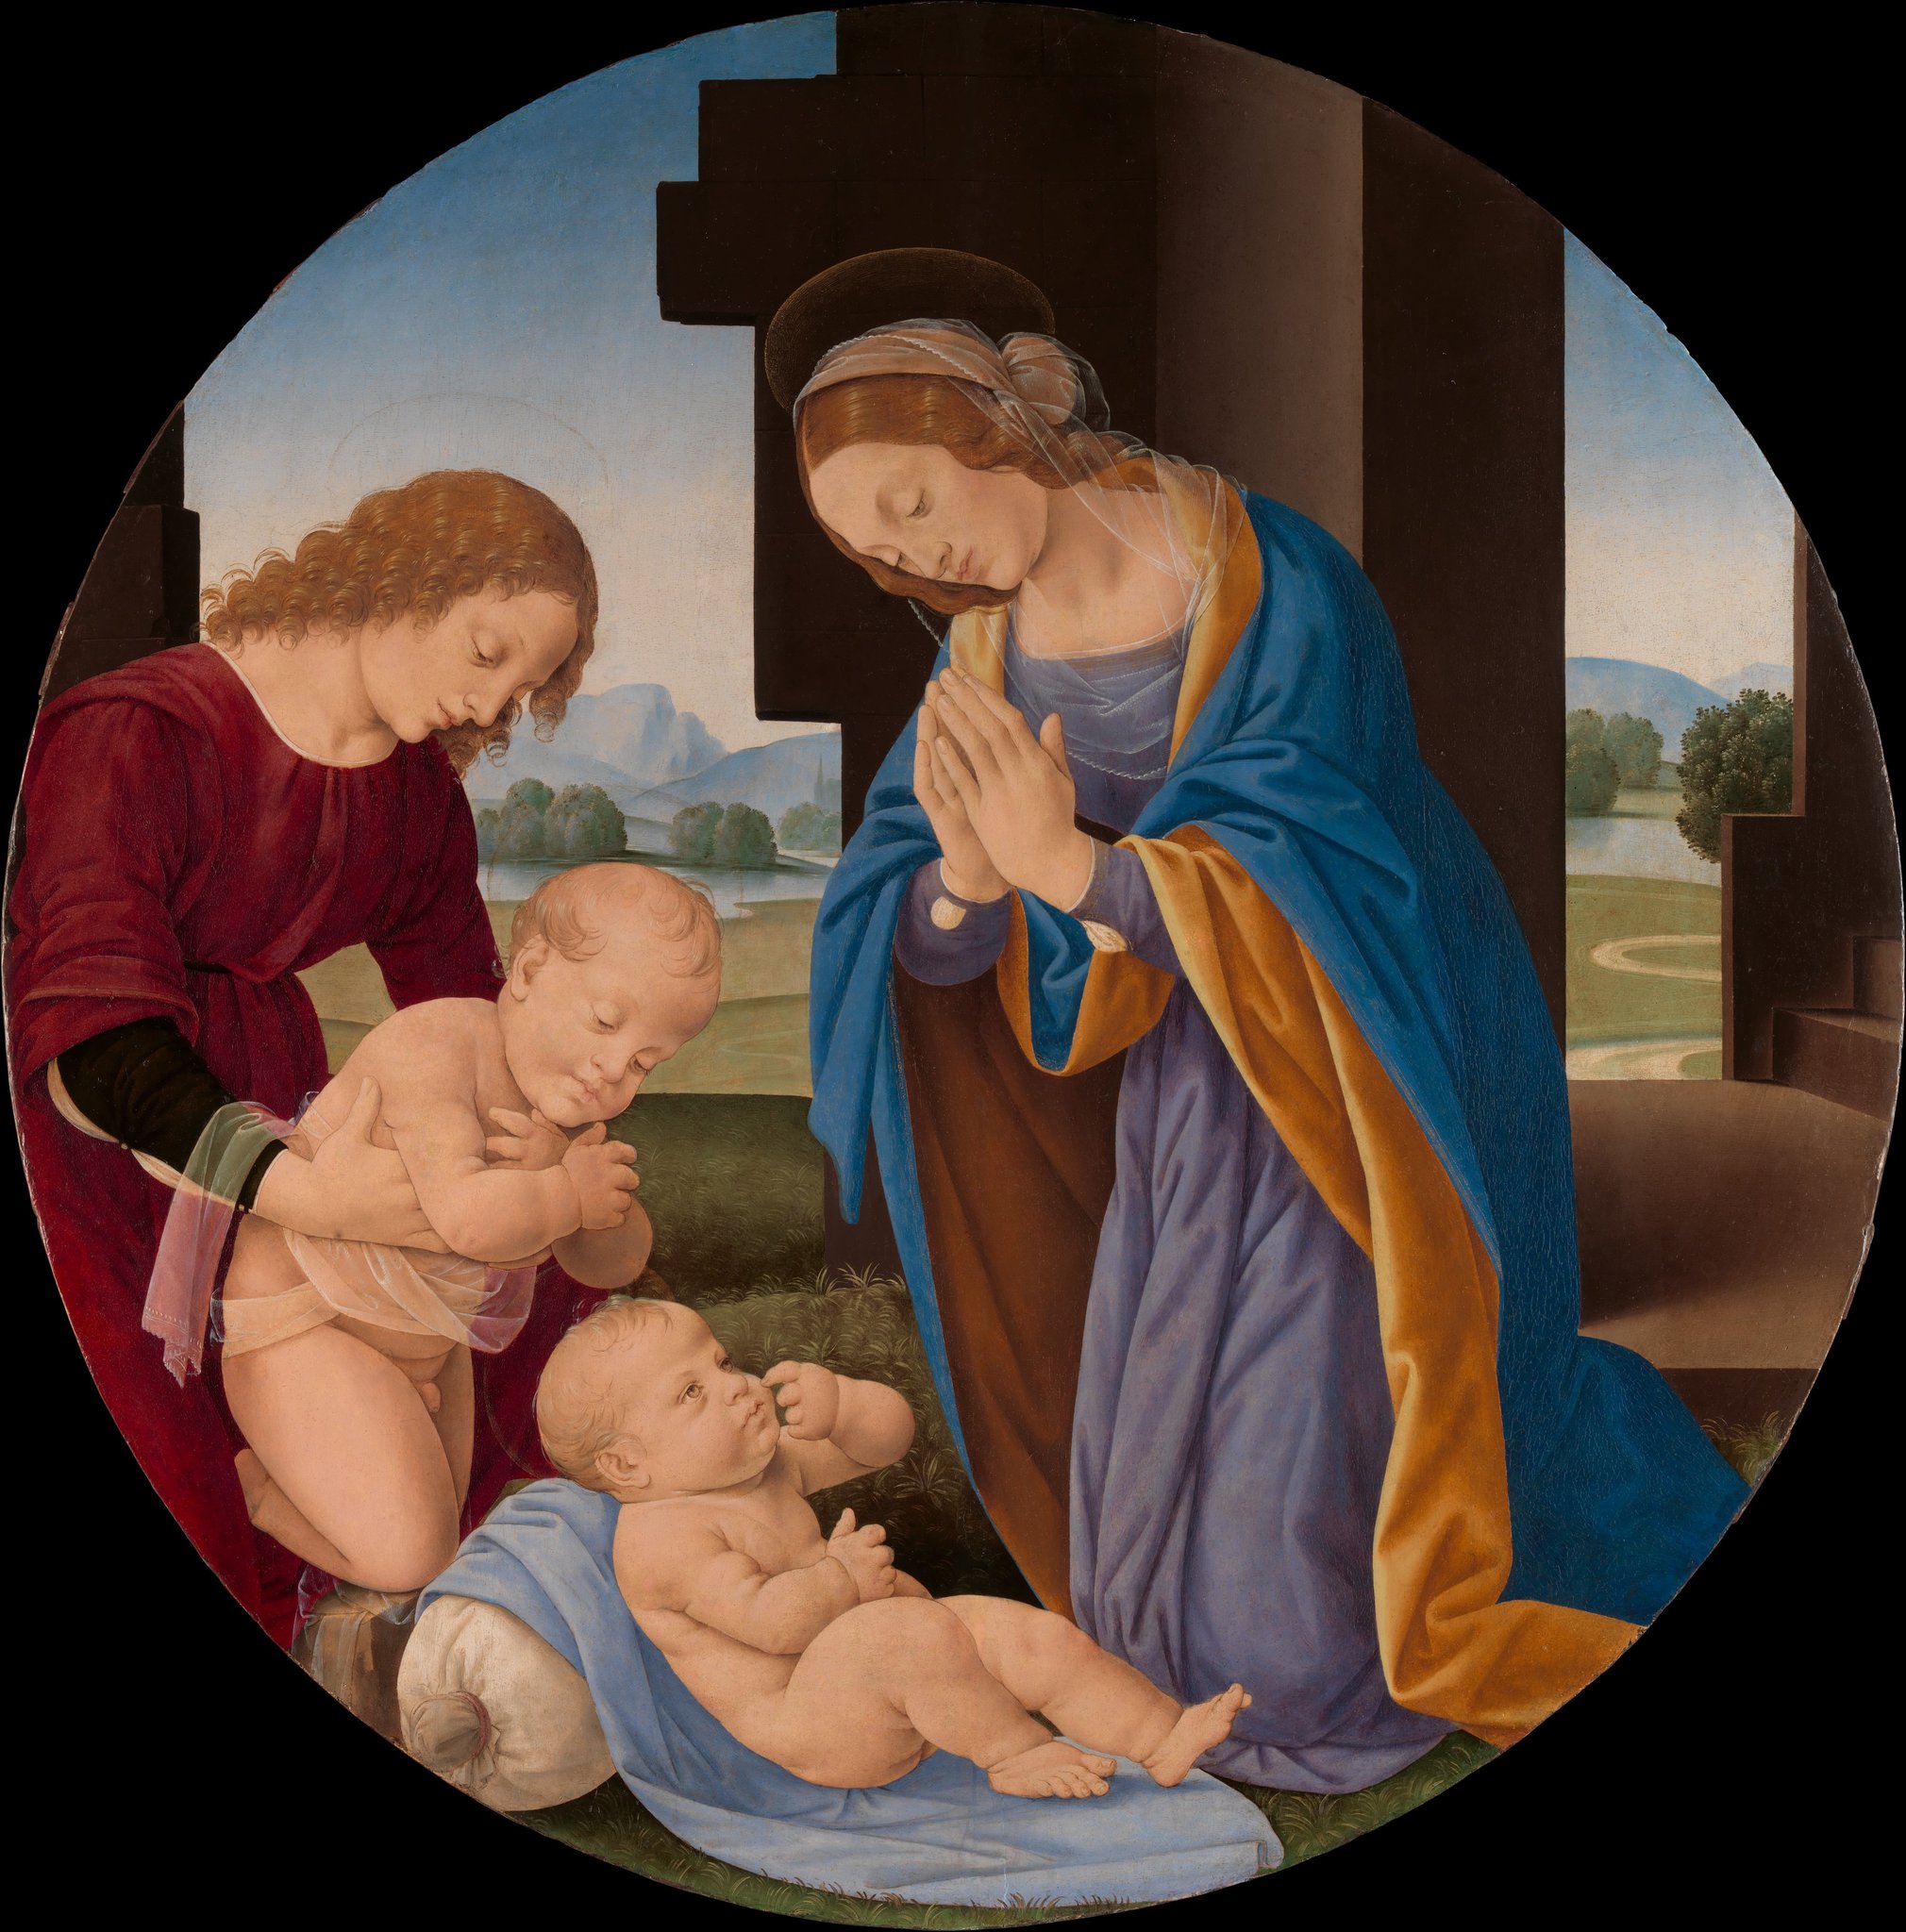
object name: painting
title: Madonna Adoring the Child with the Infant Saint John the Baptist and an Angel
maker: lorenzo di credi (lorenzo d'andrea d'oderigo)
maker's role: artist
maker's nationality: italian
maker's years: 1456-1536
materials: paint, wood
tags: angels,christ,madonna and child,saint john the baptist